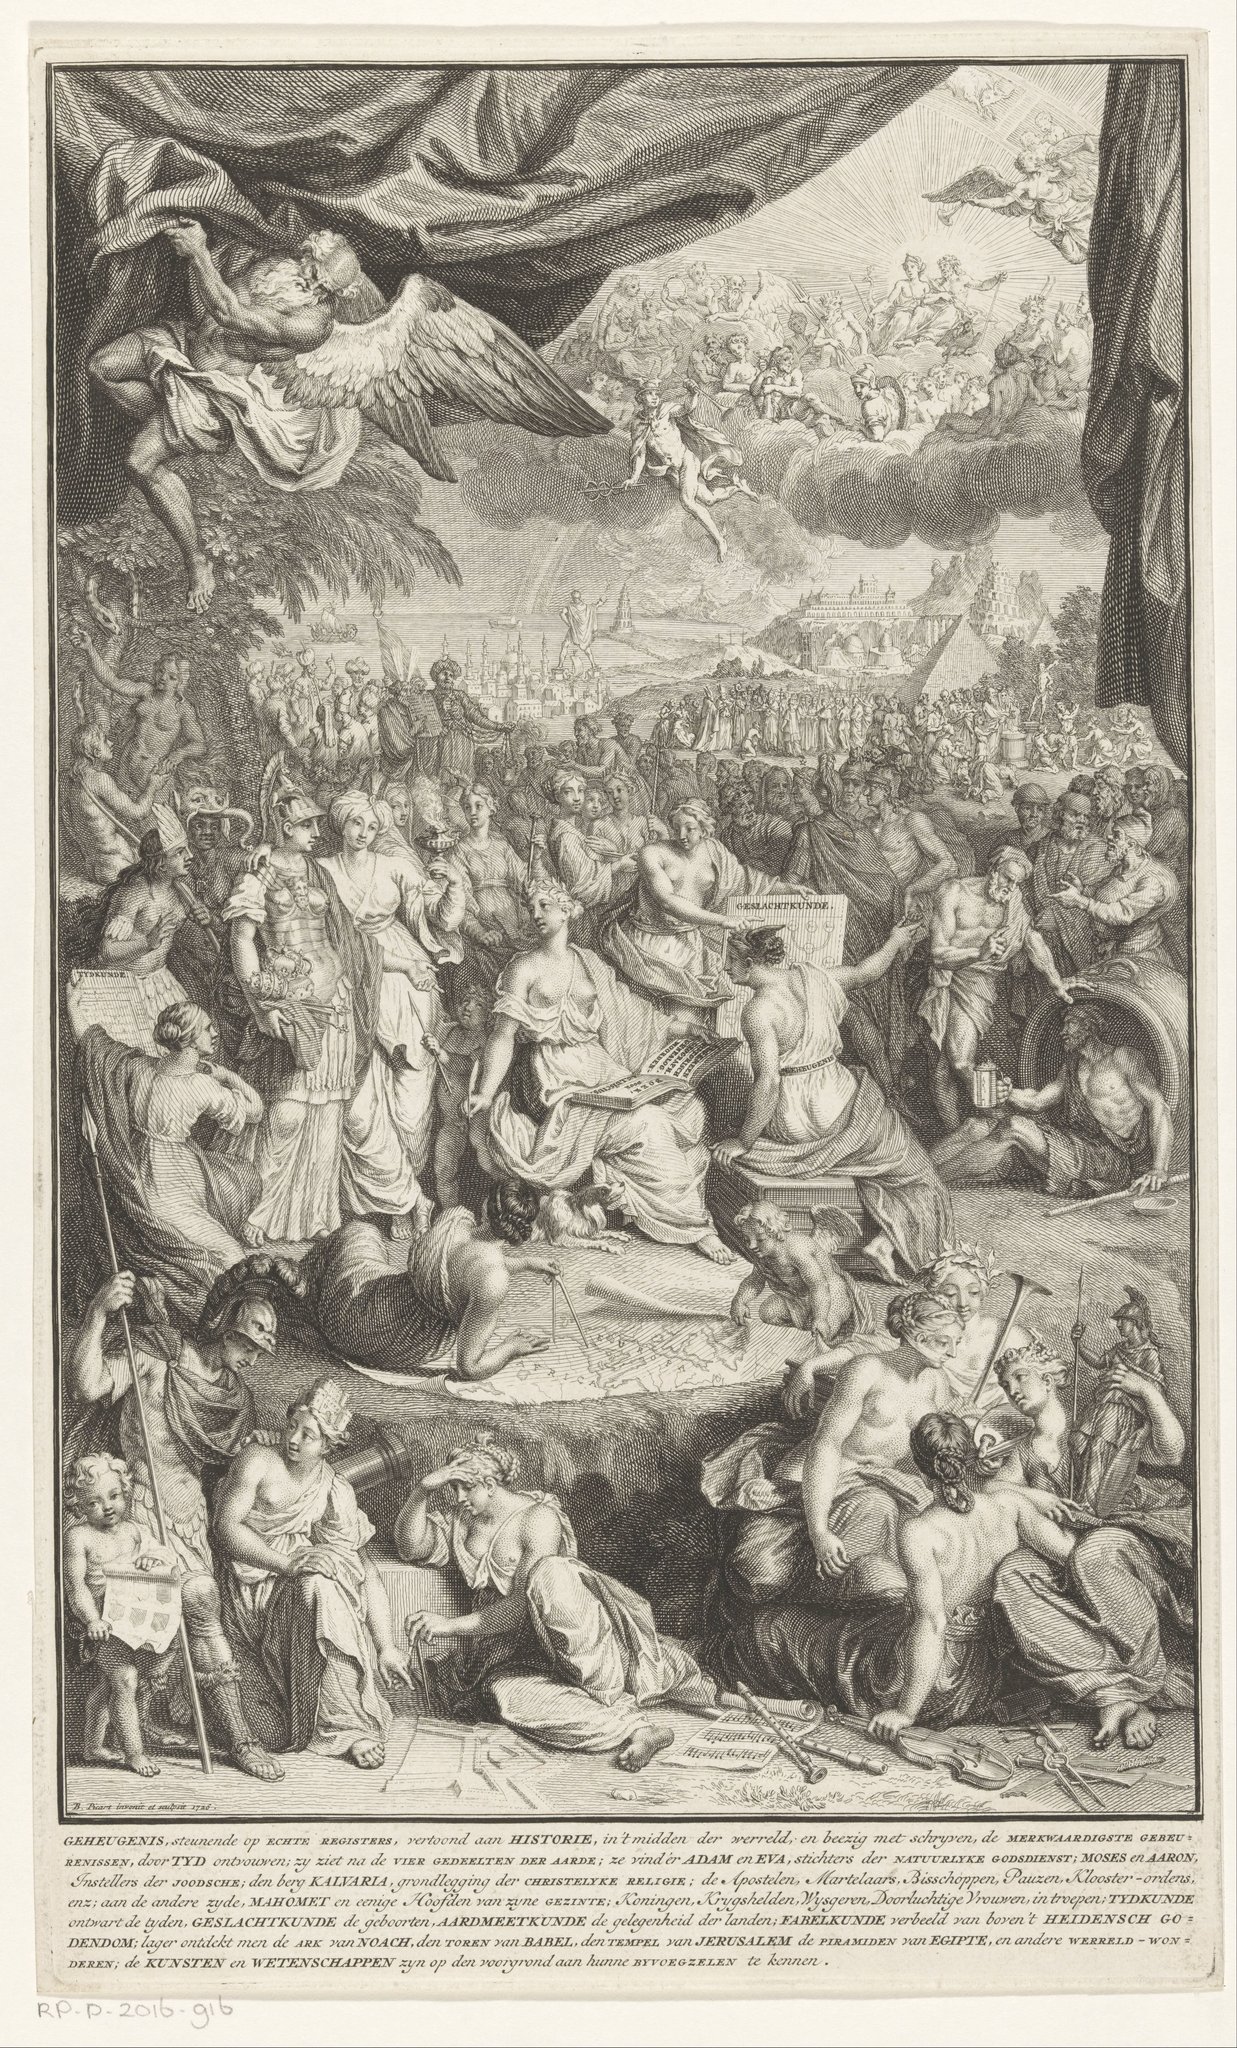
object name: print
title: Allegorie met Geschiedenis die de historie schrijft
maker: bernard picart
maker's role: draughtsman, print maker, publisher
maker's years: 1673-1733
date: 1724-1737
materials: paper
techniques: engraving, etching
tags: symbolic representations, allegories and emblems ~ art; 'arte' (ripa), 'historia'; 'historia' (ripa), continents represented allegorically, father time, man with wings and scythe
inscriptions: collector's mark: Lugt 2228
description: Allegorische voorstelling, door Vader Tijd onthuld, met Geschiedenis omringd door een menigte van personages die de verschillende werelddelen symboliseren. Ze wordt vergezeld door Genealogie, die haar een stamboom toont, Chronologie, met tablet in de hand, Geografie, die met haar passer de wereldkaart tekent en Mnemosyne, de godin van het geheugen, die naar Diogenes wijst. Op de voorgrond de personificaties van de kunsten met hun attributen. Links op de achtergrond Adam en Eva, Mohammed, Mozes en Aäron. Rechts op de achtergrond monumenten waaronder de kolos van Rhodos, de toren van Babel, Golgota, piramiden en de tempel van Salomo. In de wolken een vergadering van de Olympische goden. In de marge een zevenregelig onderschrift in het Nederlands.